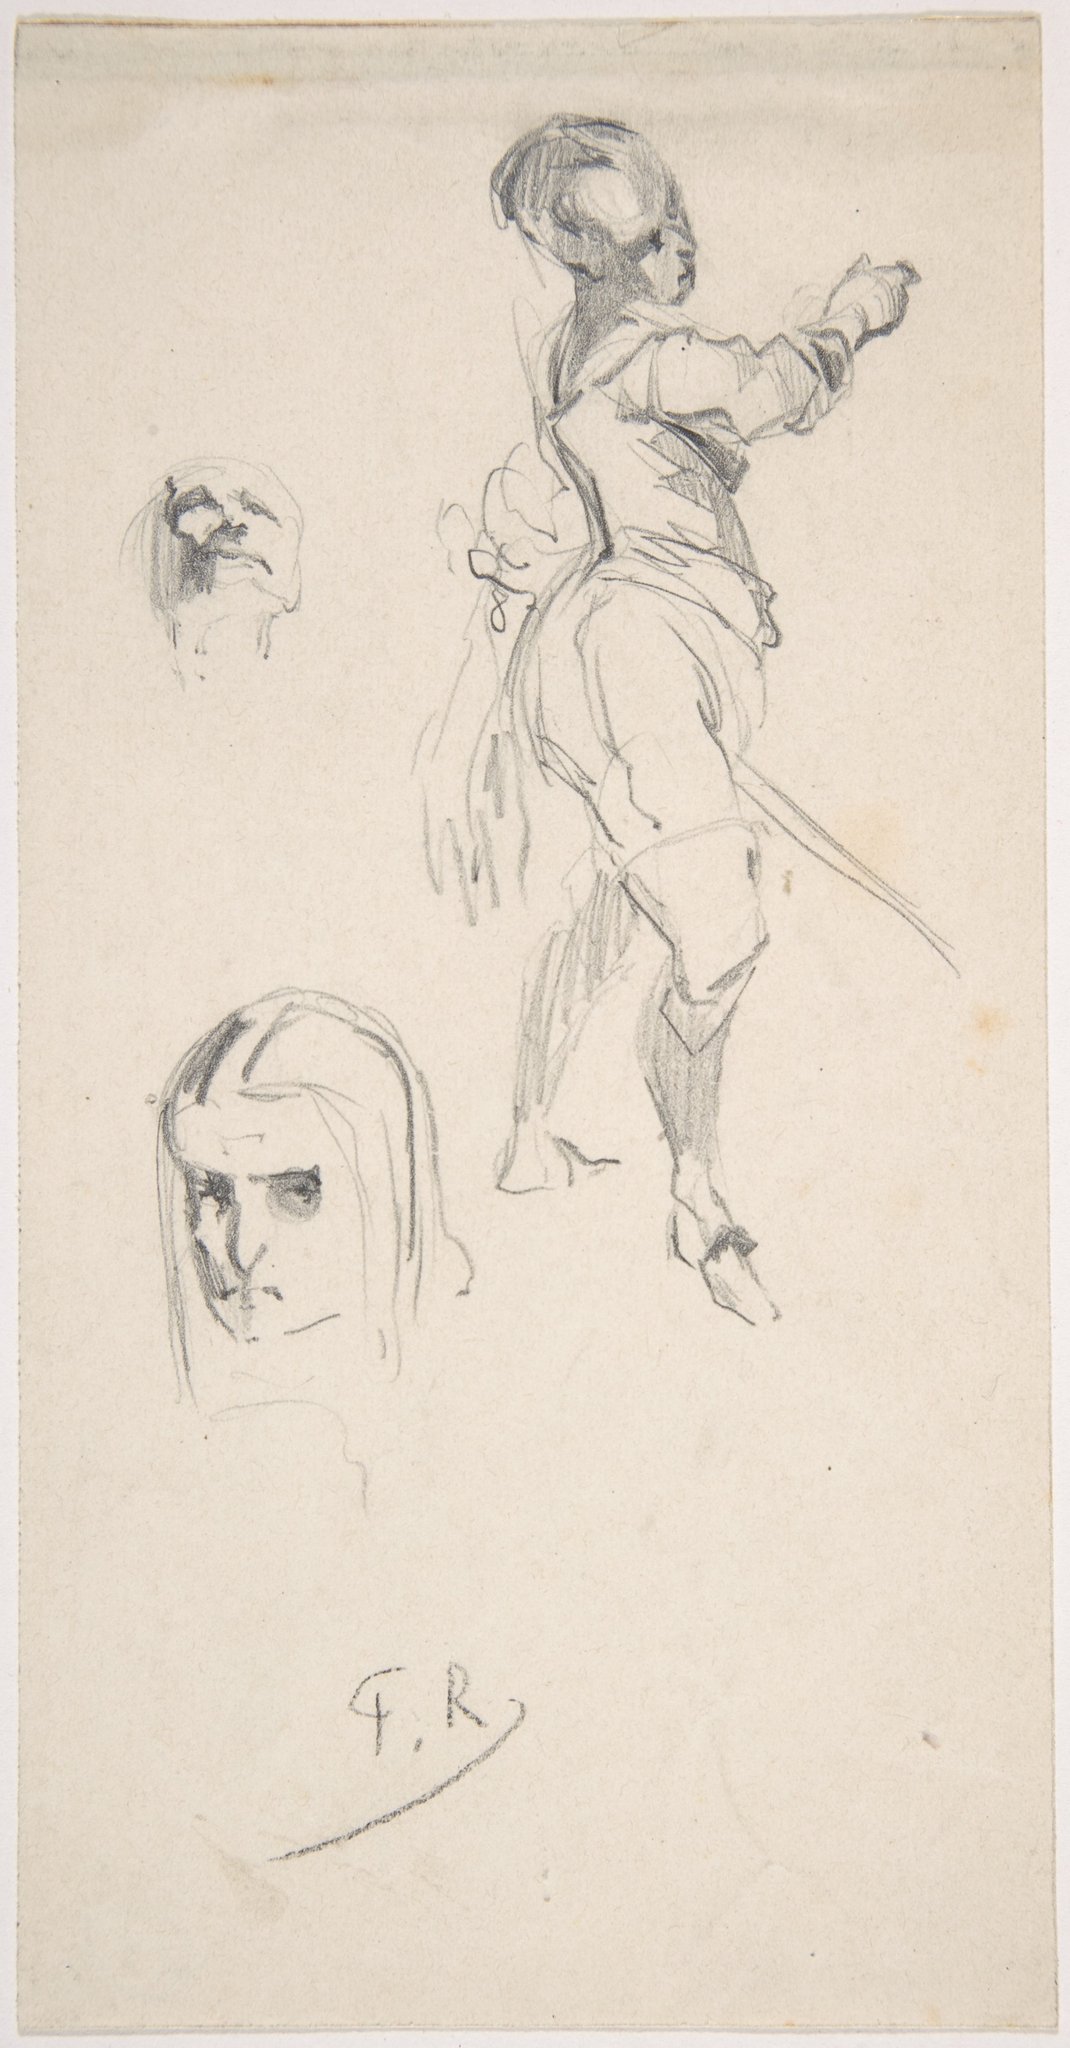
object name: drawing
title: Figure study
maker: félicien rops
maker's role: artist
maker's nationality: belgian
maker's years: 1833-1898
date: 1833-1898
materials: graphite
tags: heads,men,women